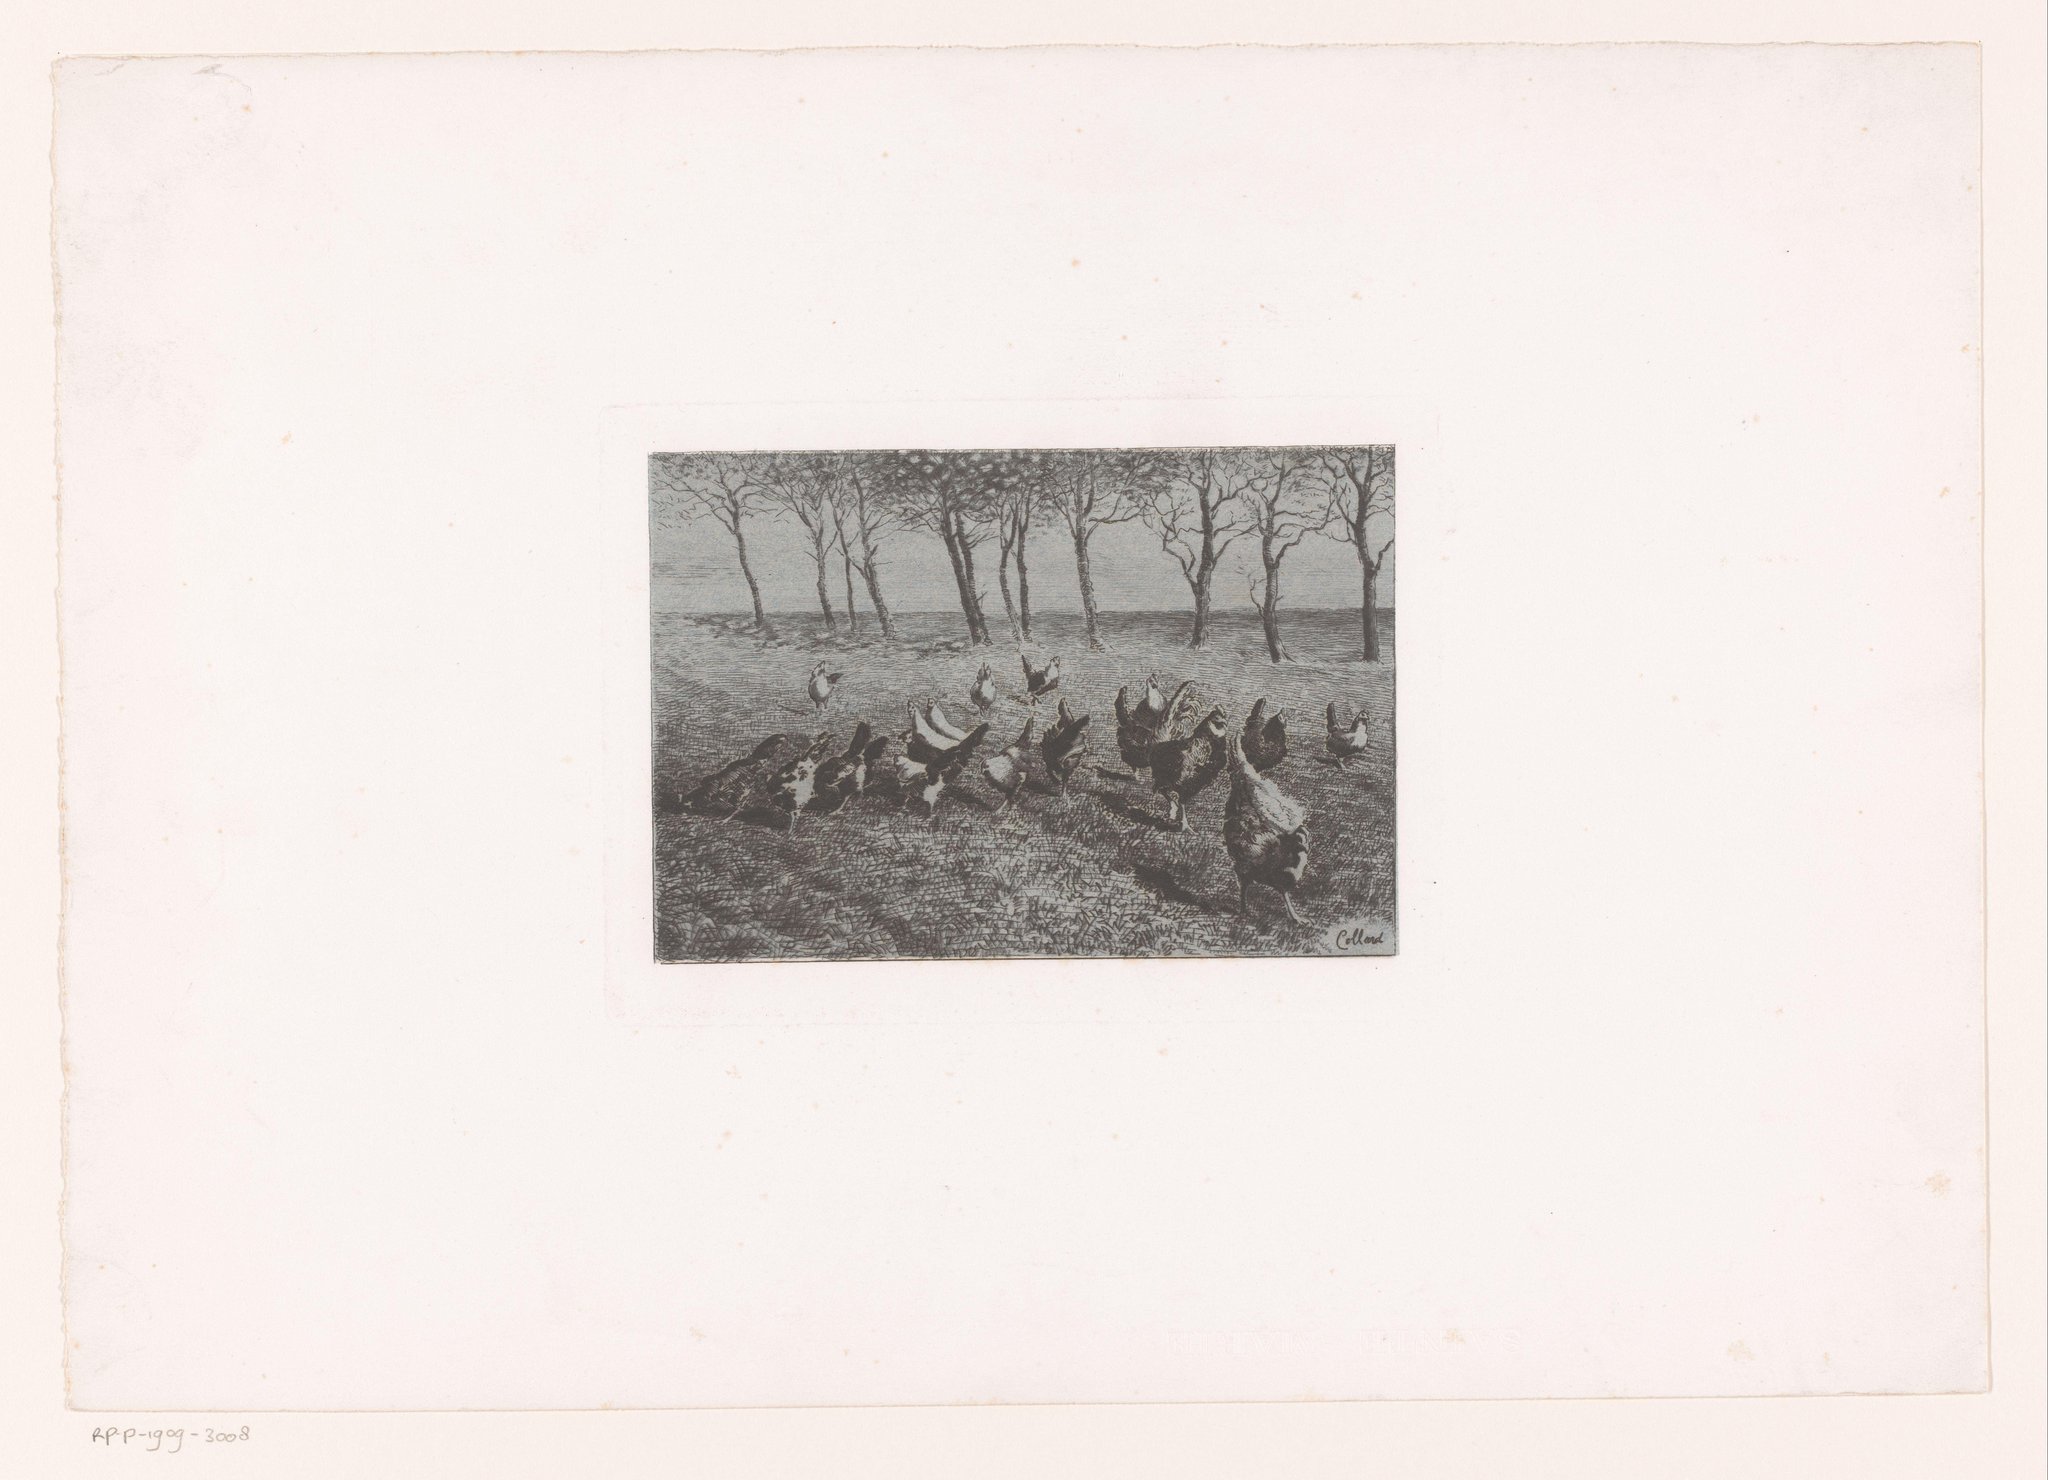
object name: print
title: Weide met kippen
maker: armand collard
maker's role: print maker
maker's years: 1838-1910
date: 1848-1909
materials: paper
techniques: etching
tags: fowl (cock, hen, chicken, etc.)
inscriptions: mark: ‘Sainte Marie’, collector's mark: Lugt 2228